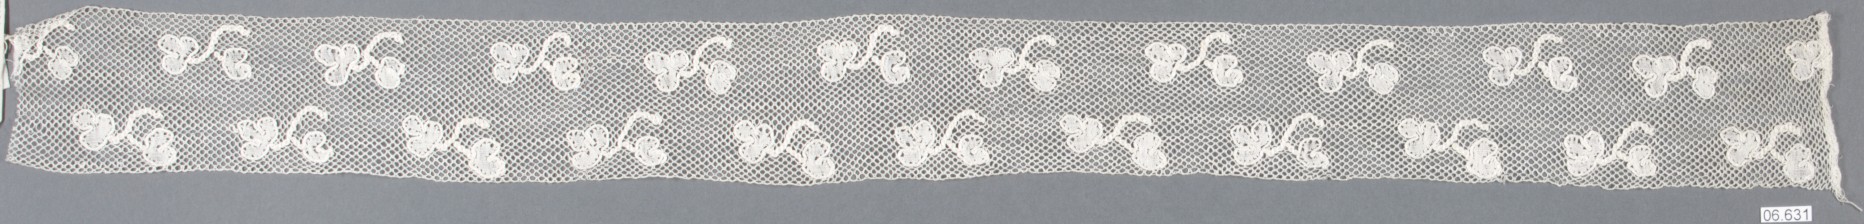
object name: insertion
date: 1800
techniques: lace